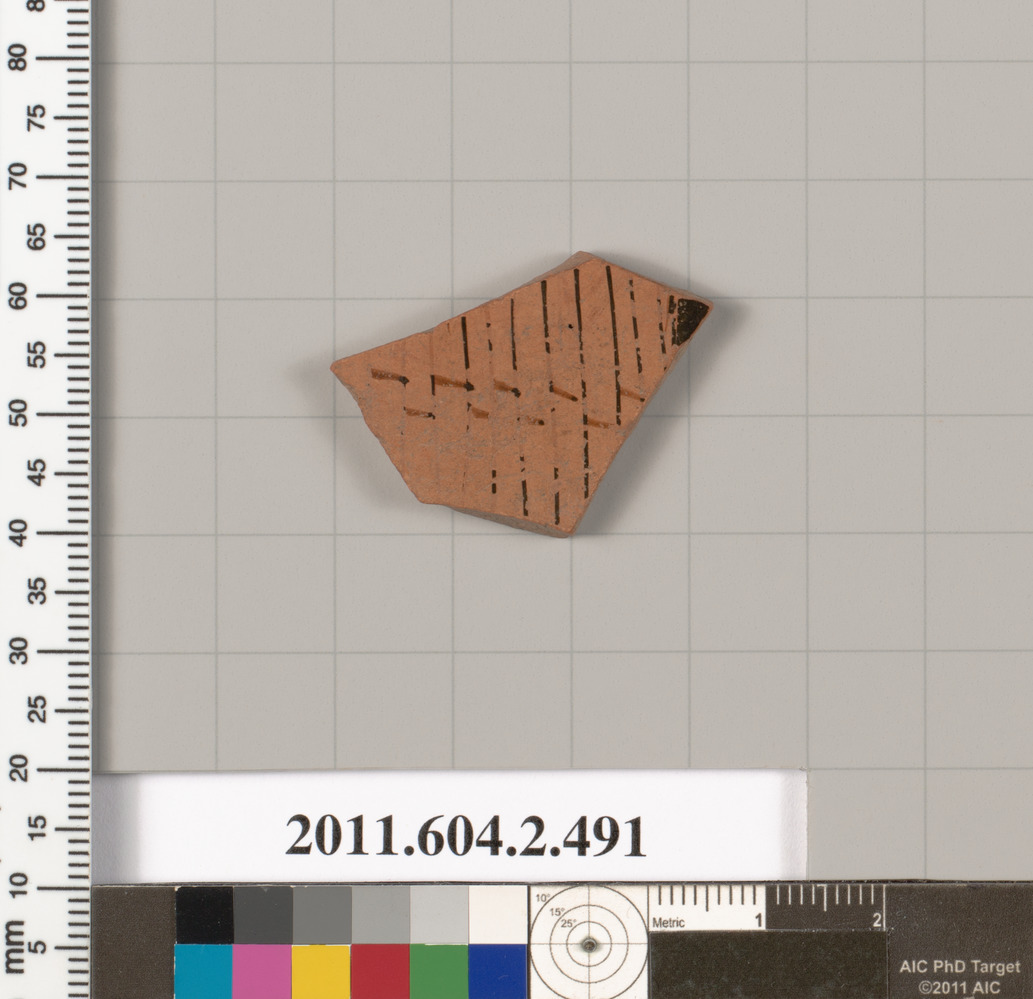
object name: column krater fragment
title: Terracotta fragment of a column-krater (bowl for mixing wine and water)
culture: greek, attic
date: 460-440 BCE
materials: terracotta